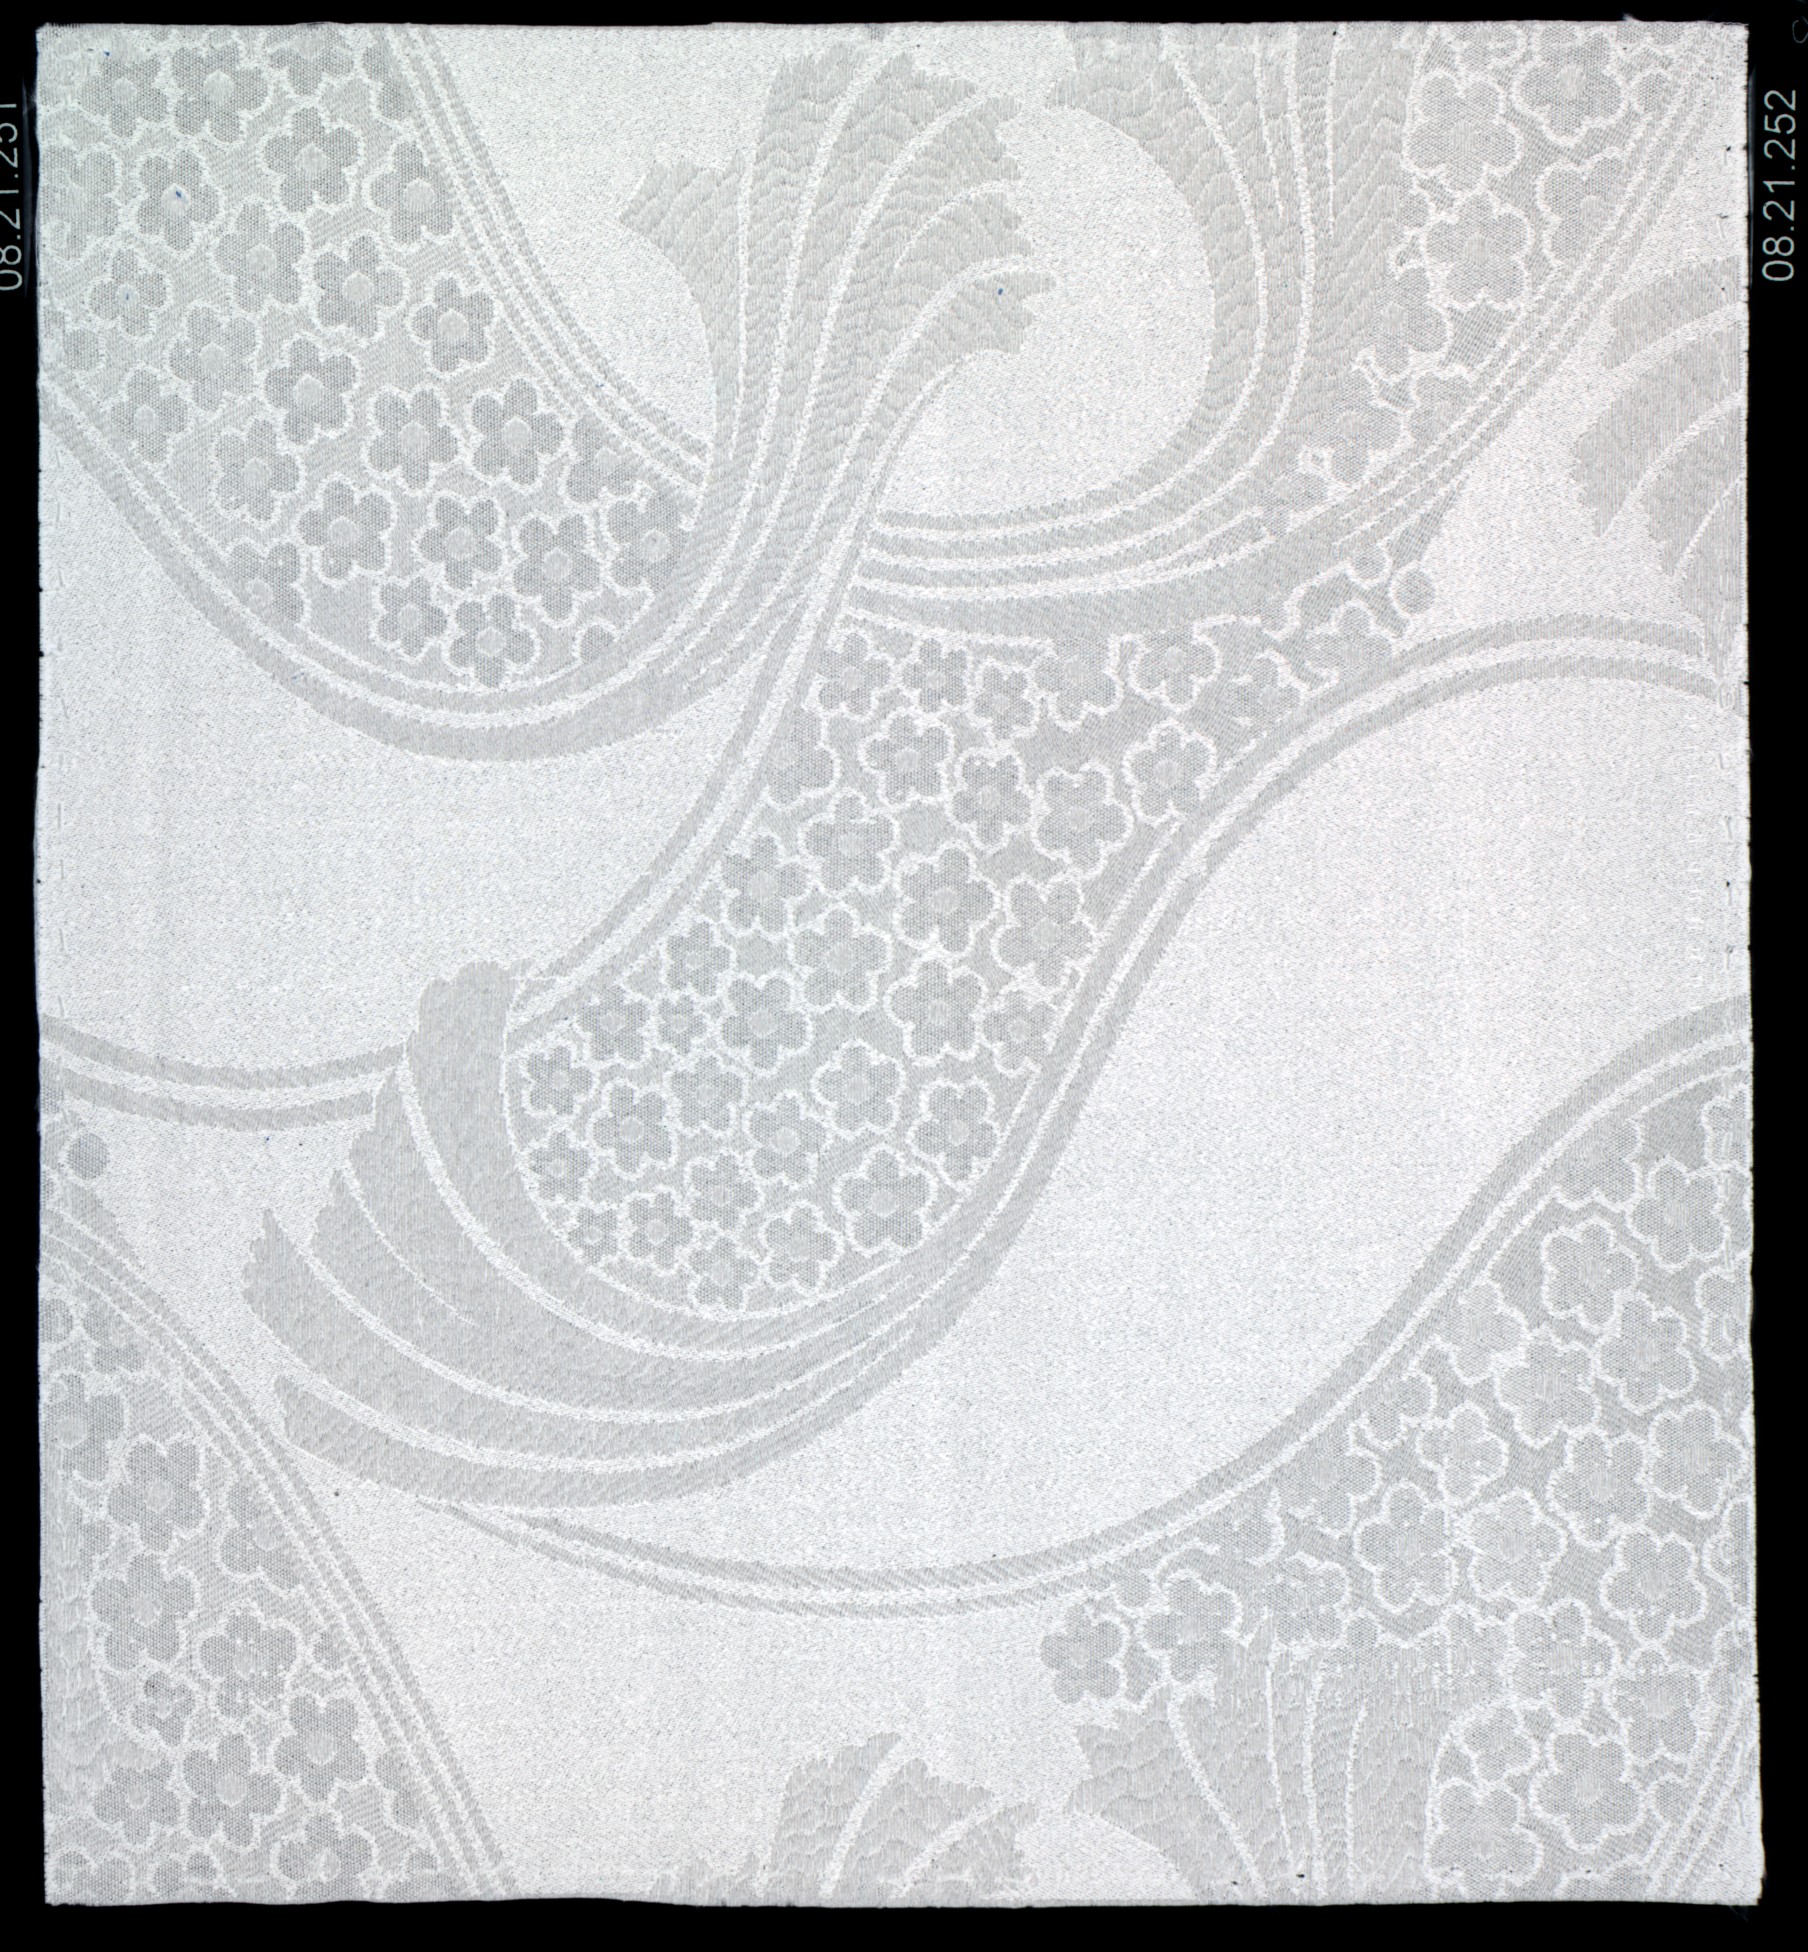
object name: textile sample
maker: Anonymous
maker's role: designer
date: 1900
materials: silk